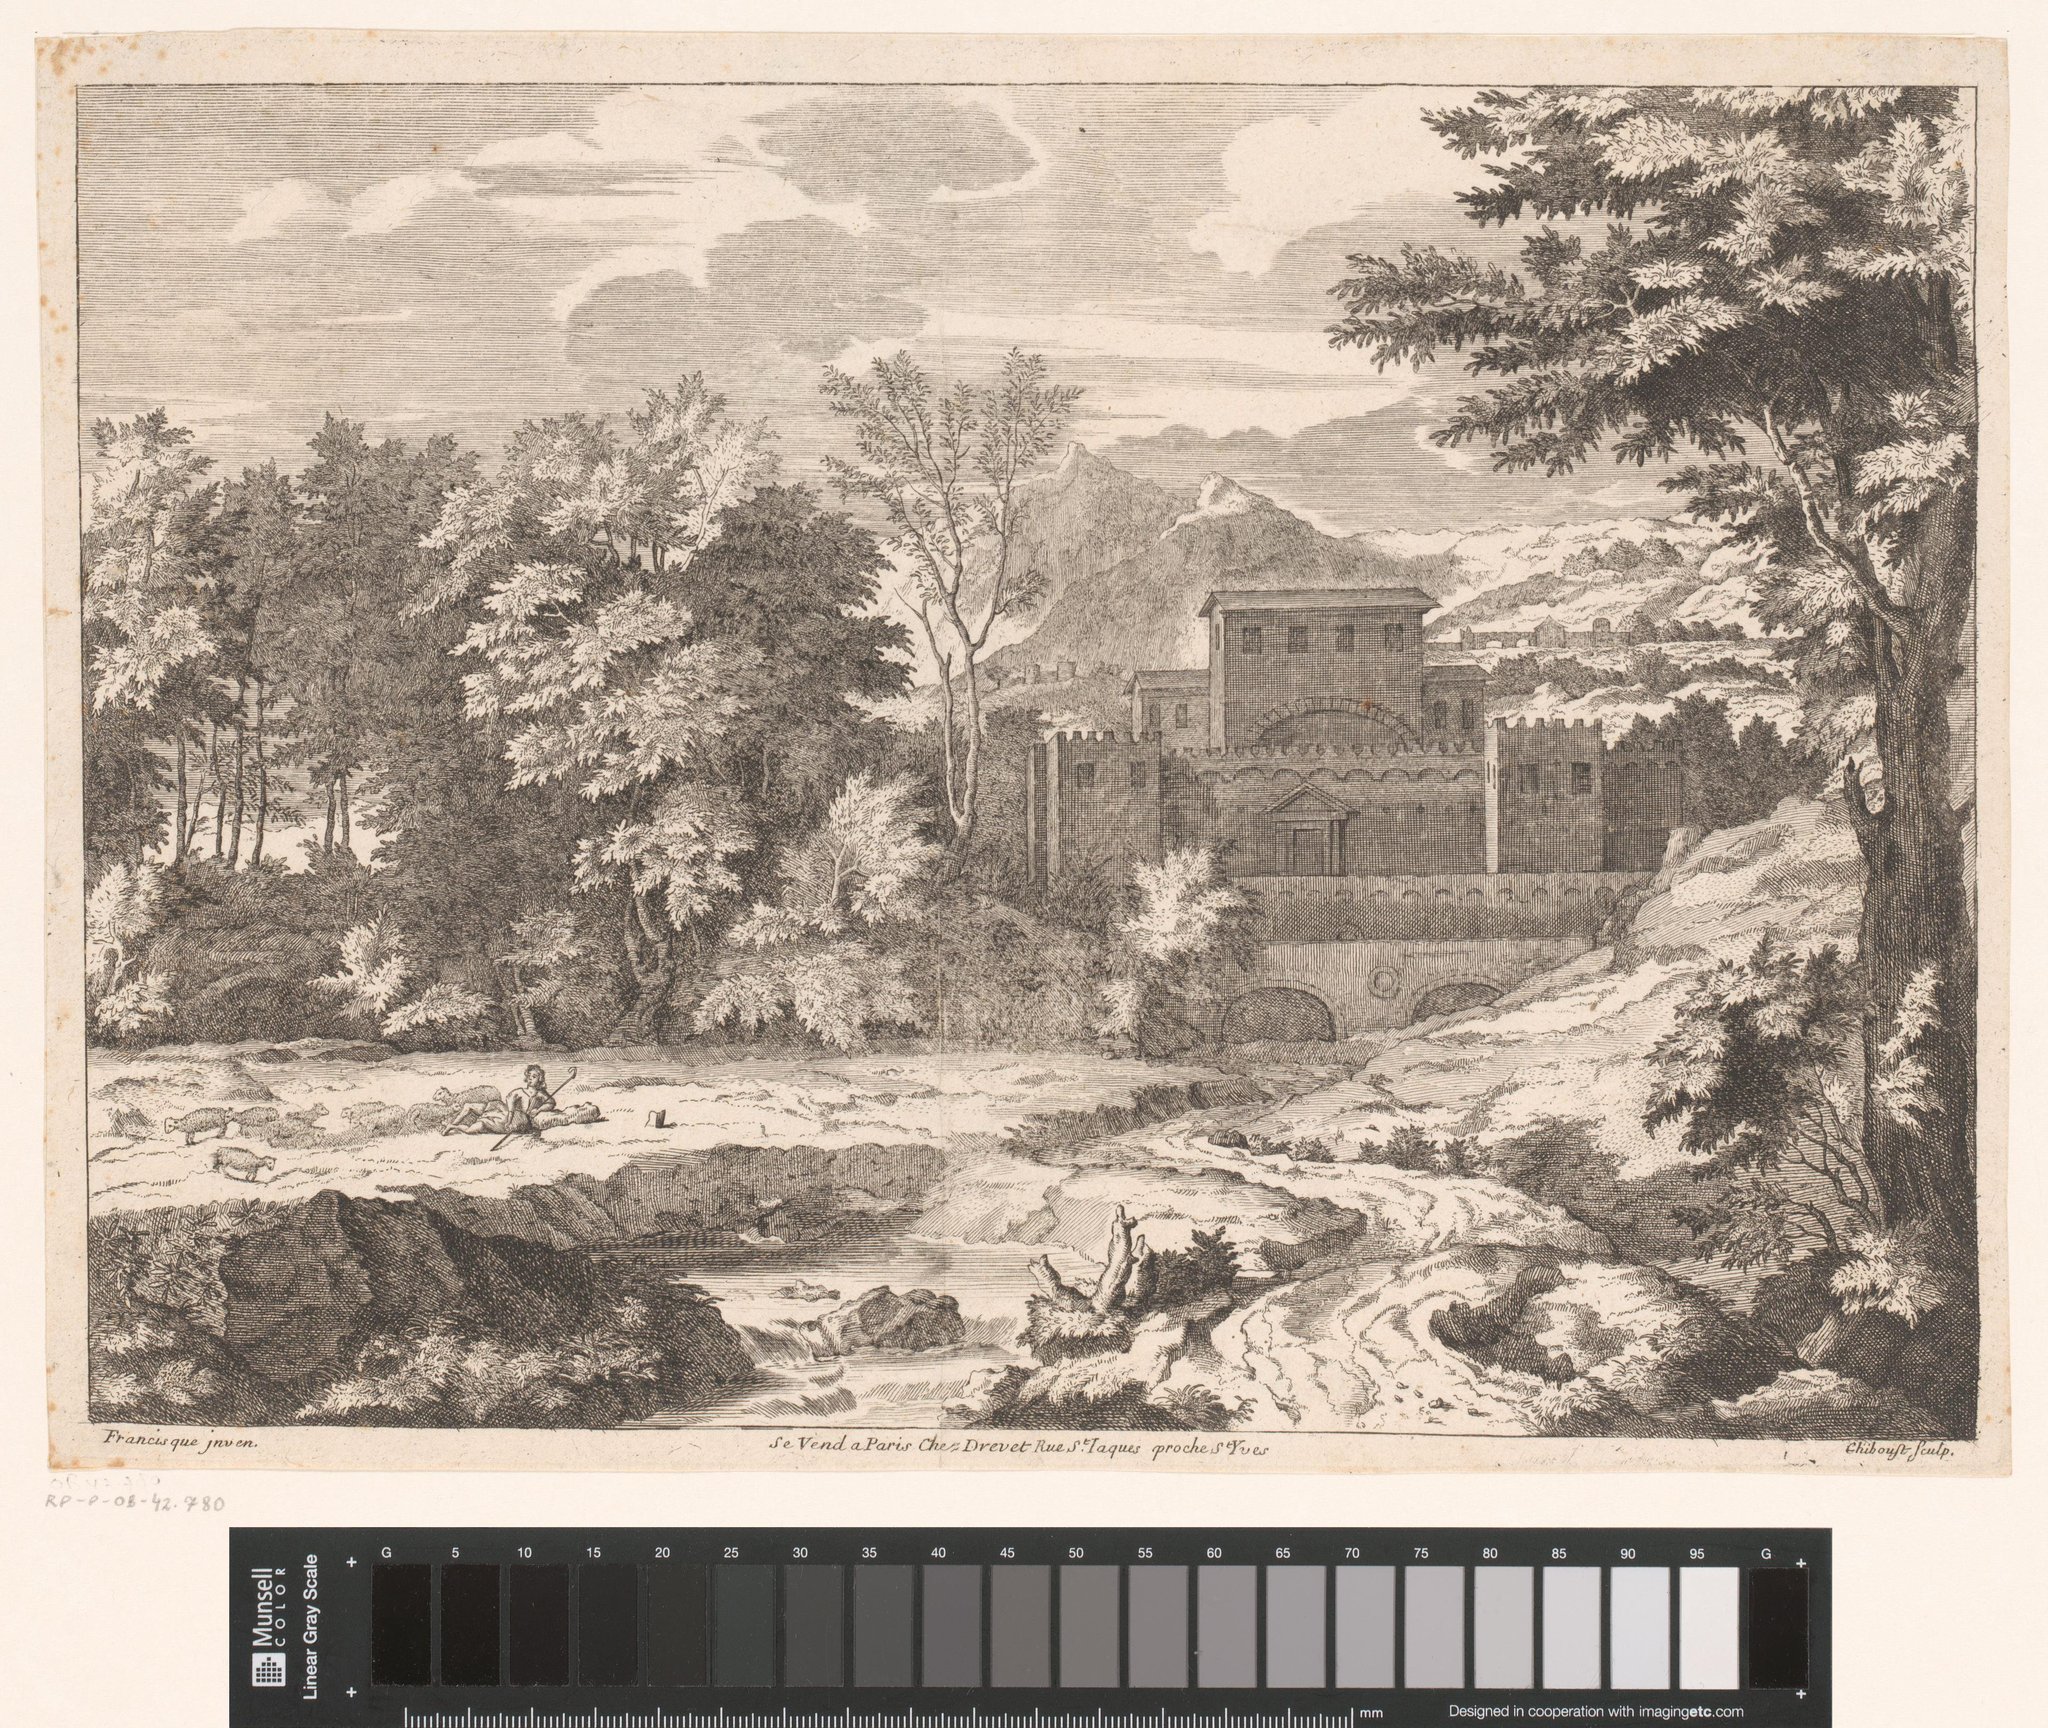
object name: print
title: Rivierlandschap met burcht en rustende schapenhoeder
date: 1700-1738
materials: paper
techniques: etching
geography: france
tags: river - hh - ideal landscapes, herding, herdsman, herdswoman, shepherd, shepherdess, cowherd, etc., landscape with bridge, viaduct or aqueduct, landscape with tower or castle - ii - ideal landscapes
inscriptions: collector's mark: Lugt 240